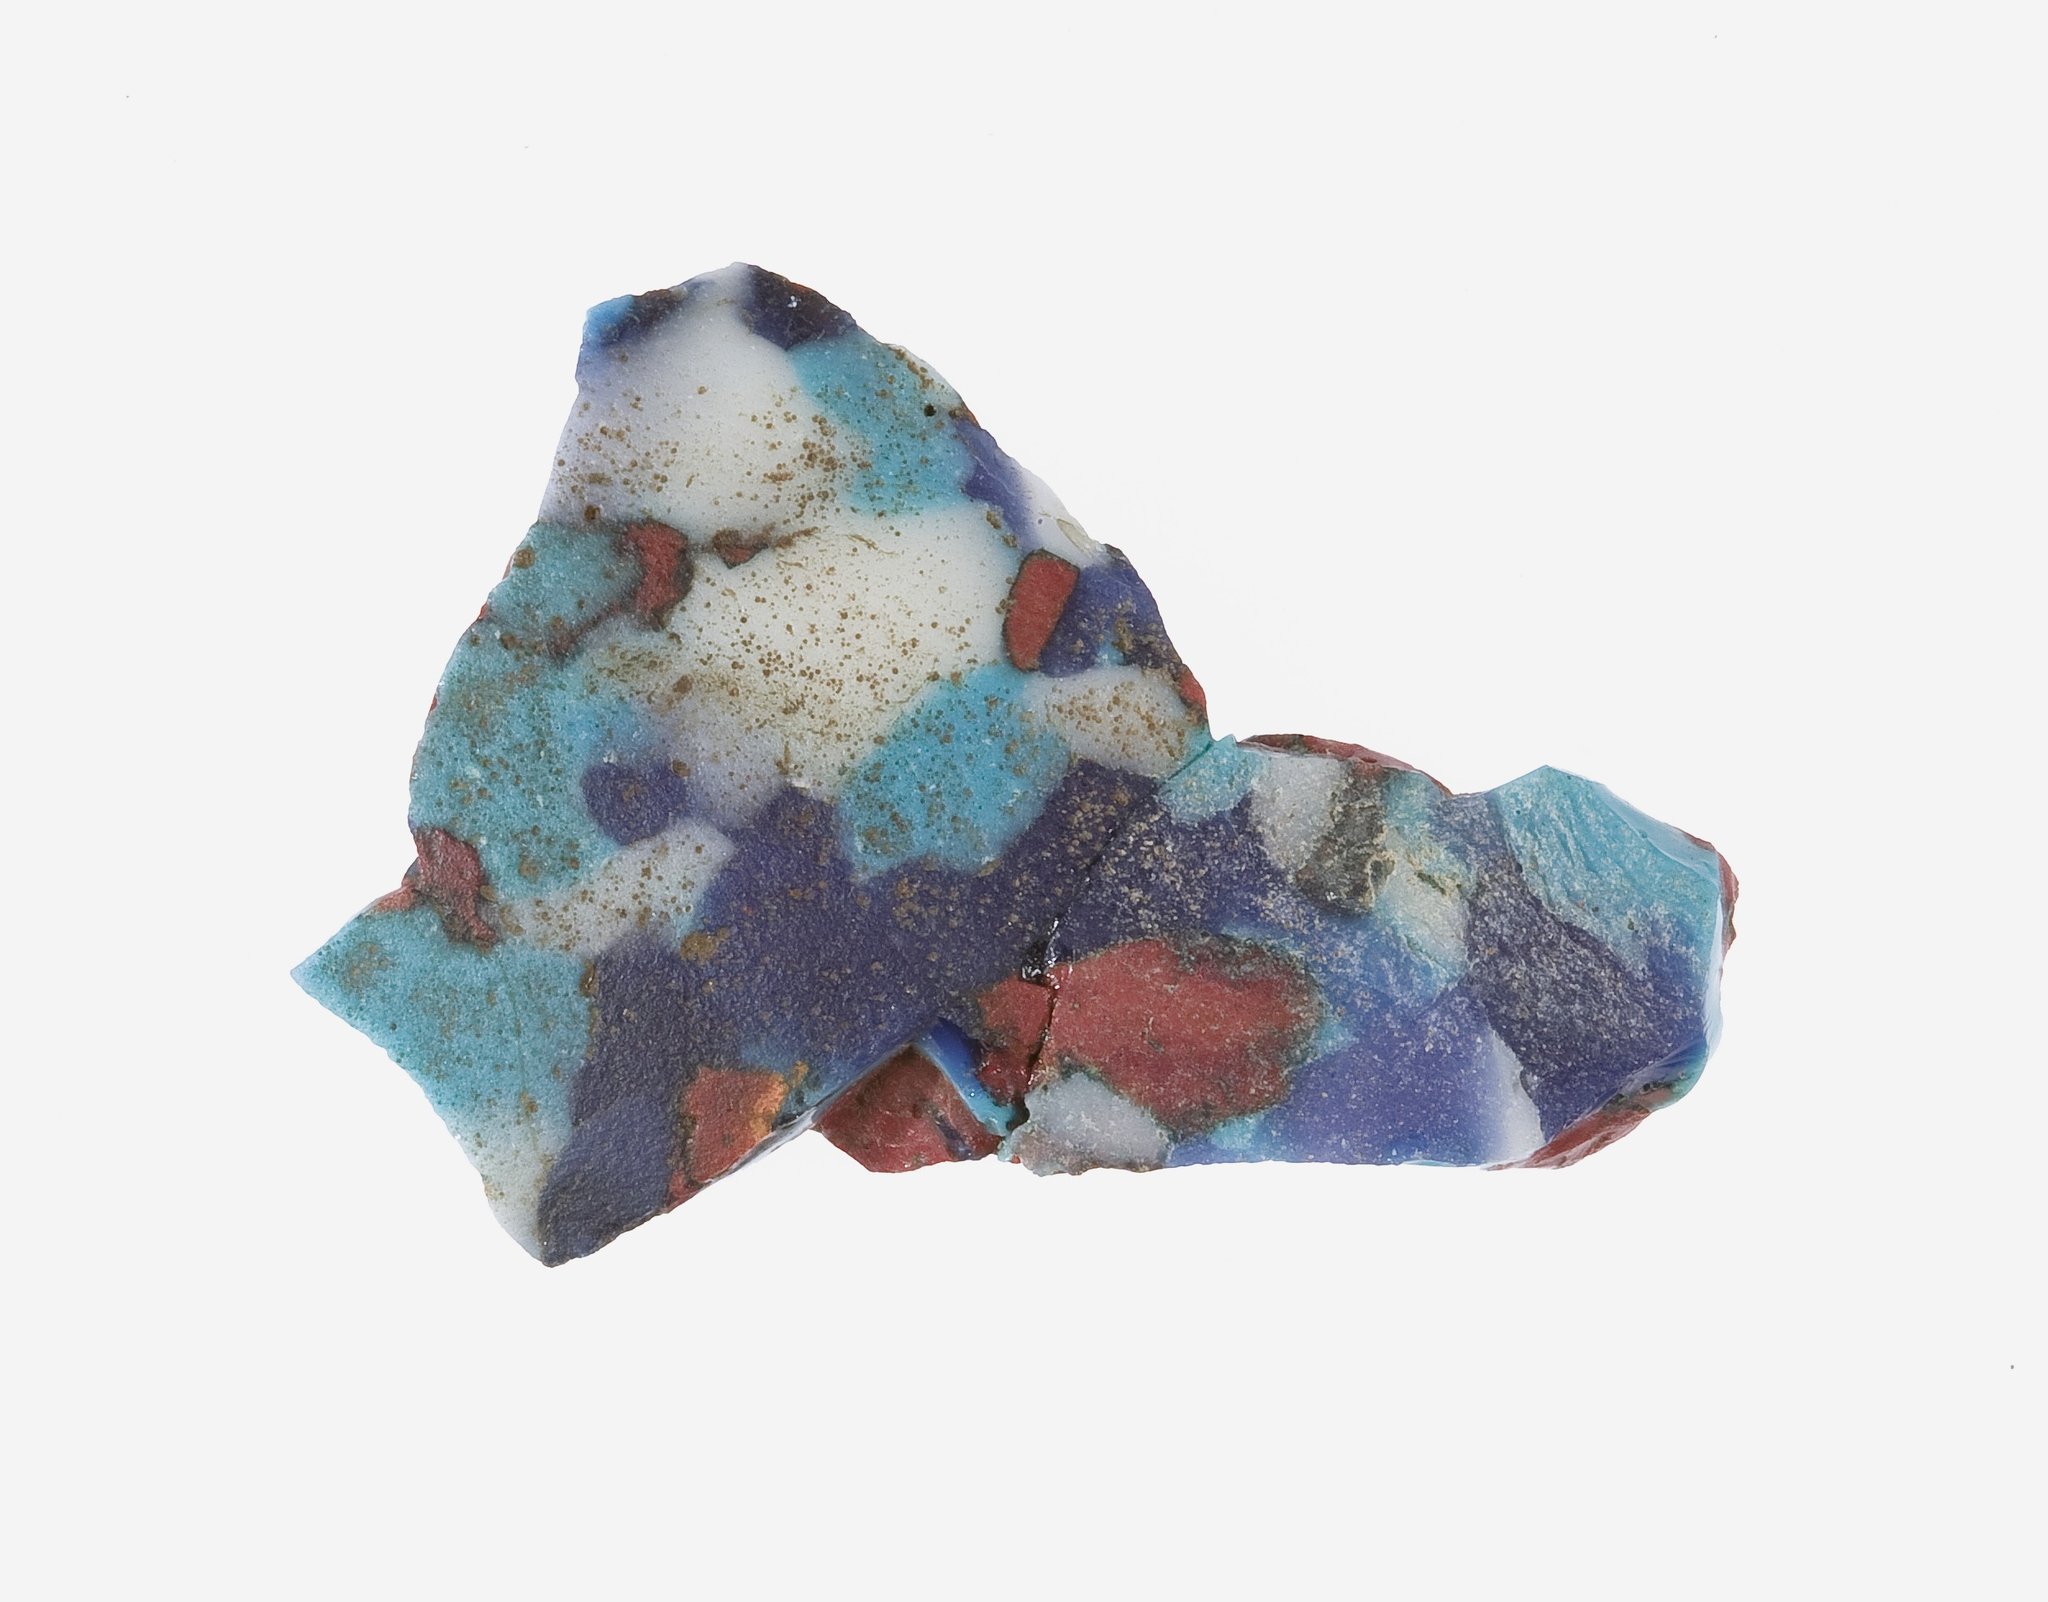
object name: vessel fragment, mosaic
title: Fragment of a Dish of Polychrome Mosaic Glass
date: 1390-1352 BCE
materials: glass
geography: egypt